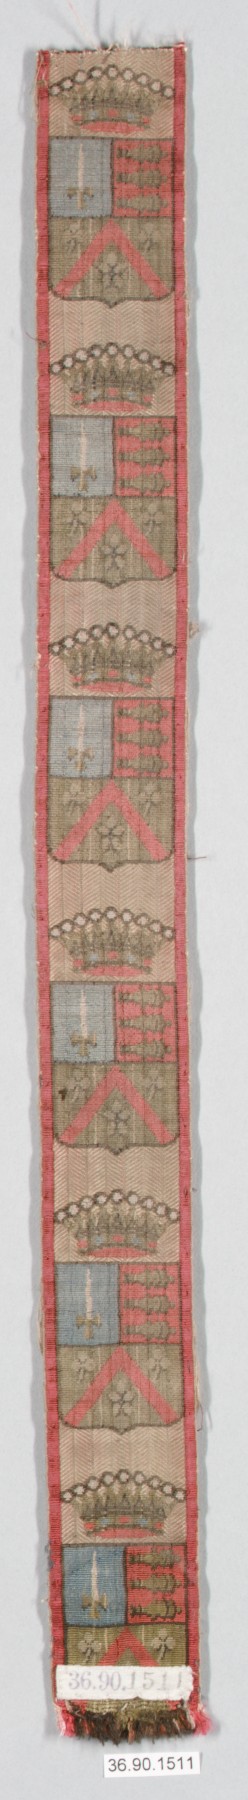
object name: galloon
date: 1701-1900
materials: metal thread, silk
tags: coat of arms